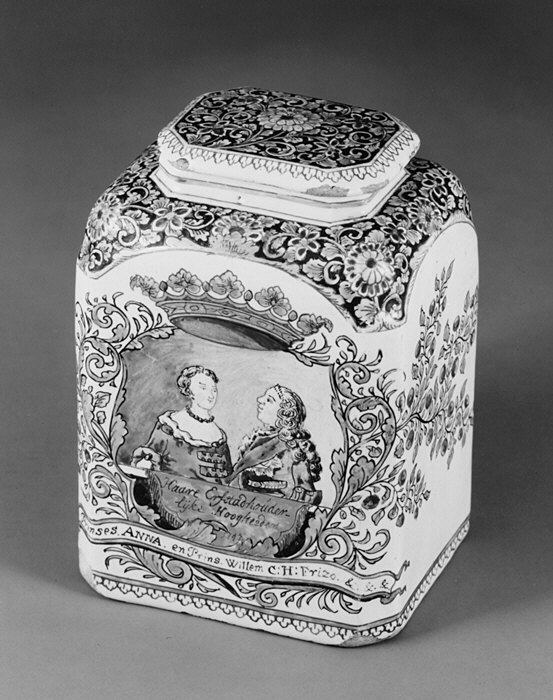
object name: tea caddy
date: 1747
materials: earthenware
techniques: glazing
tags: men,women